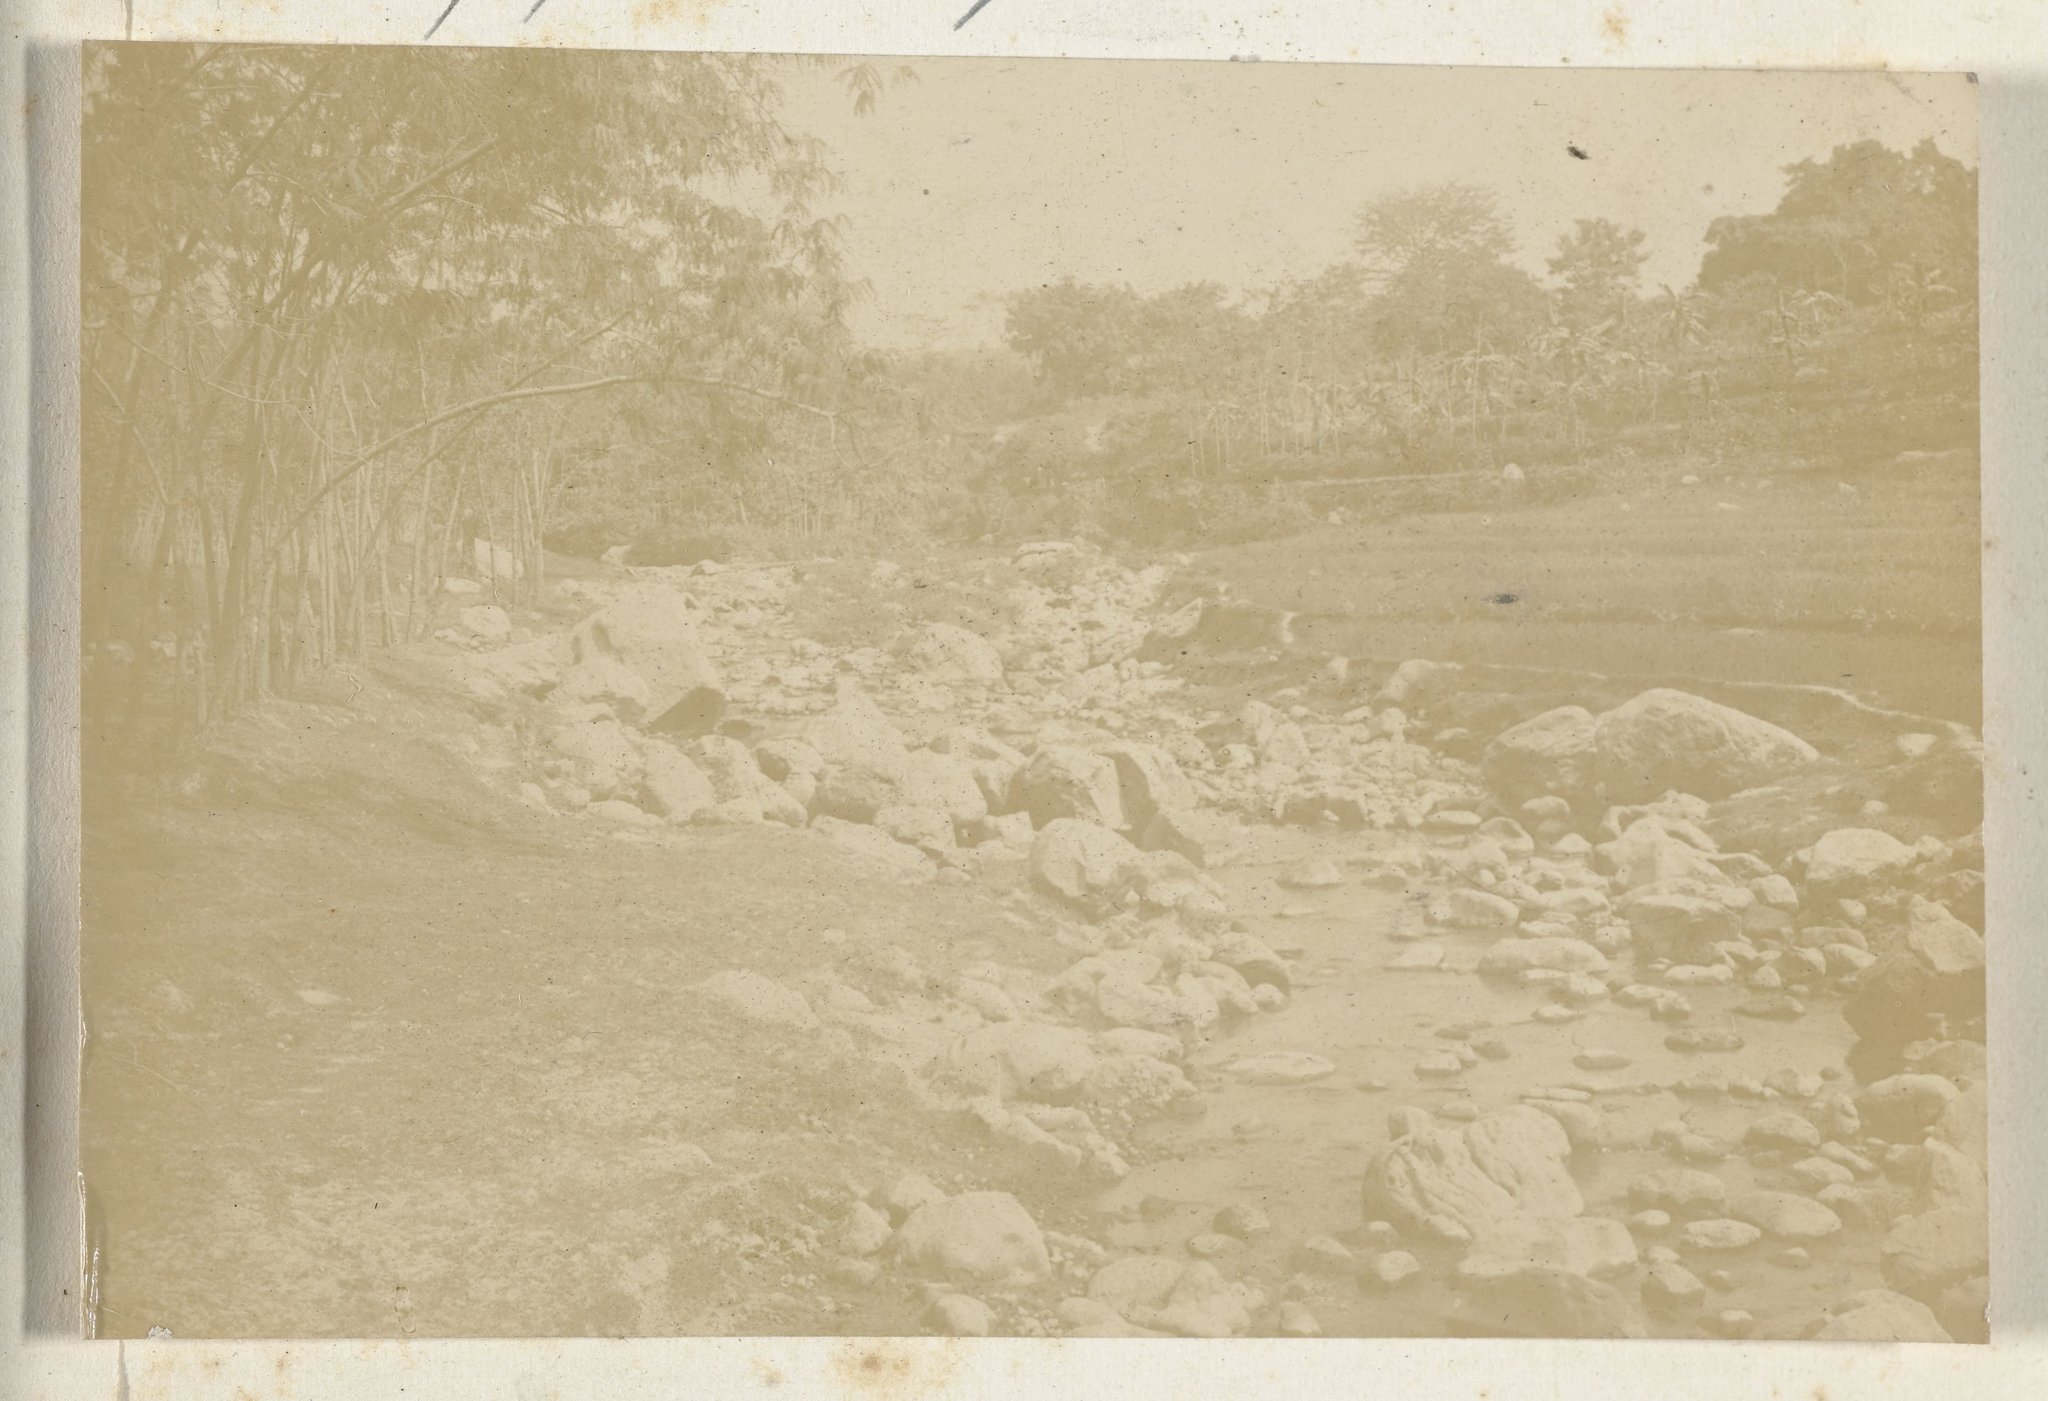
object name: photograph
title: Rotsachtig riviergezicht te Djatie Roenggo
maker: Anonymous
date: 1890-1910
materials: cardboard, paper, photographic support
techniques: gelatin silver print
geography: netherlands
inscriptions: caption: ‘Koffie planten te silo sanen’